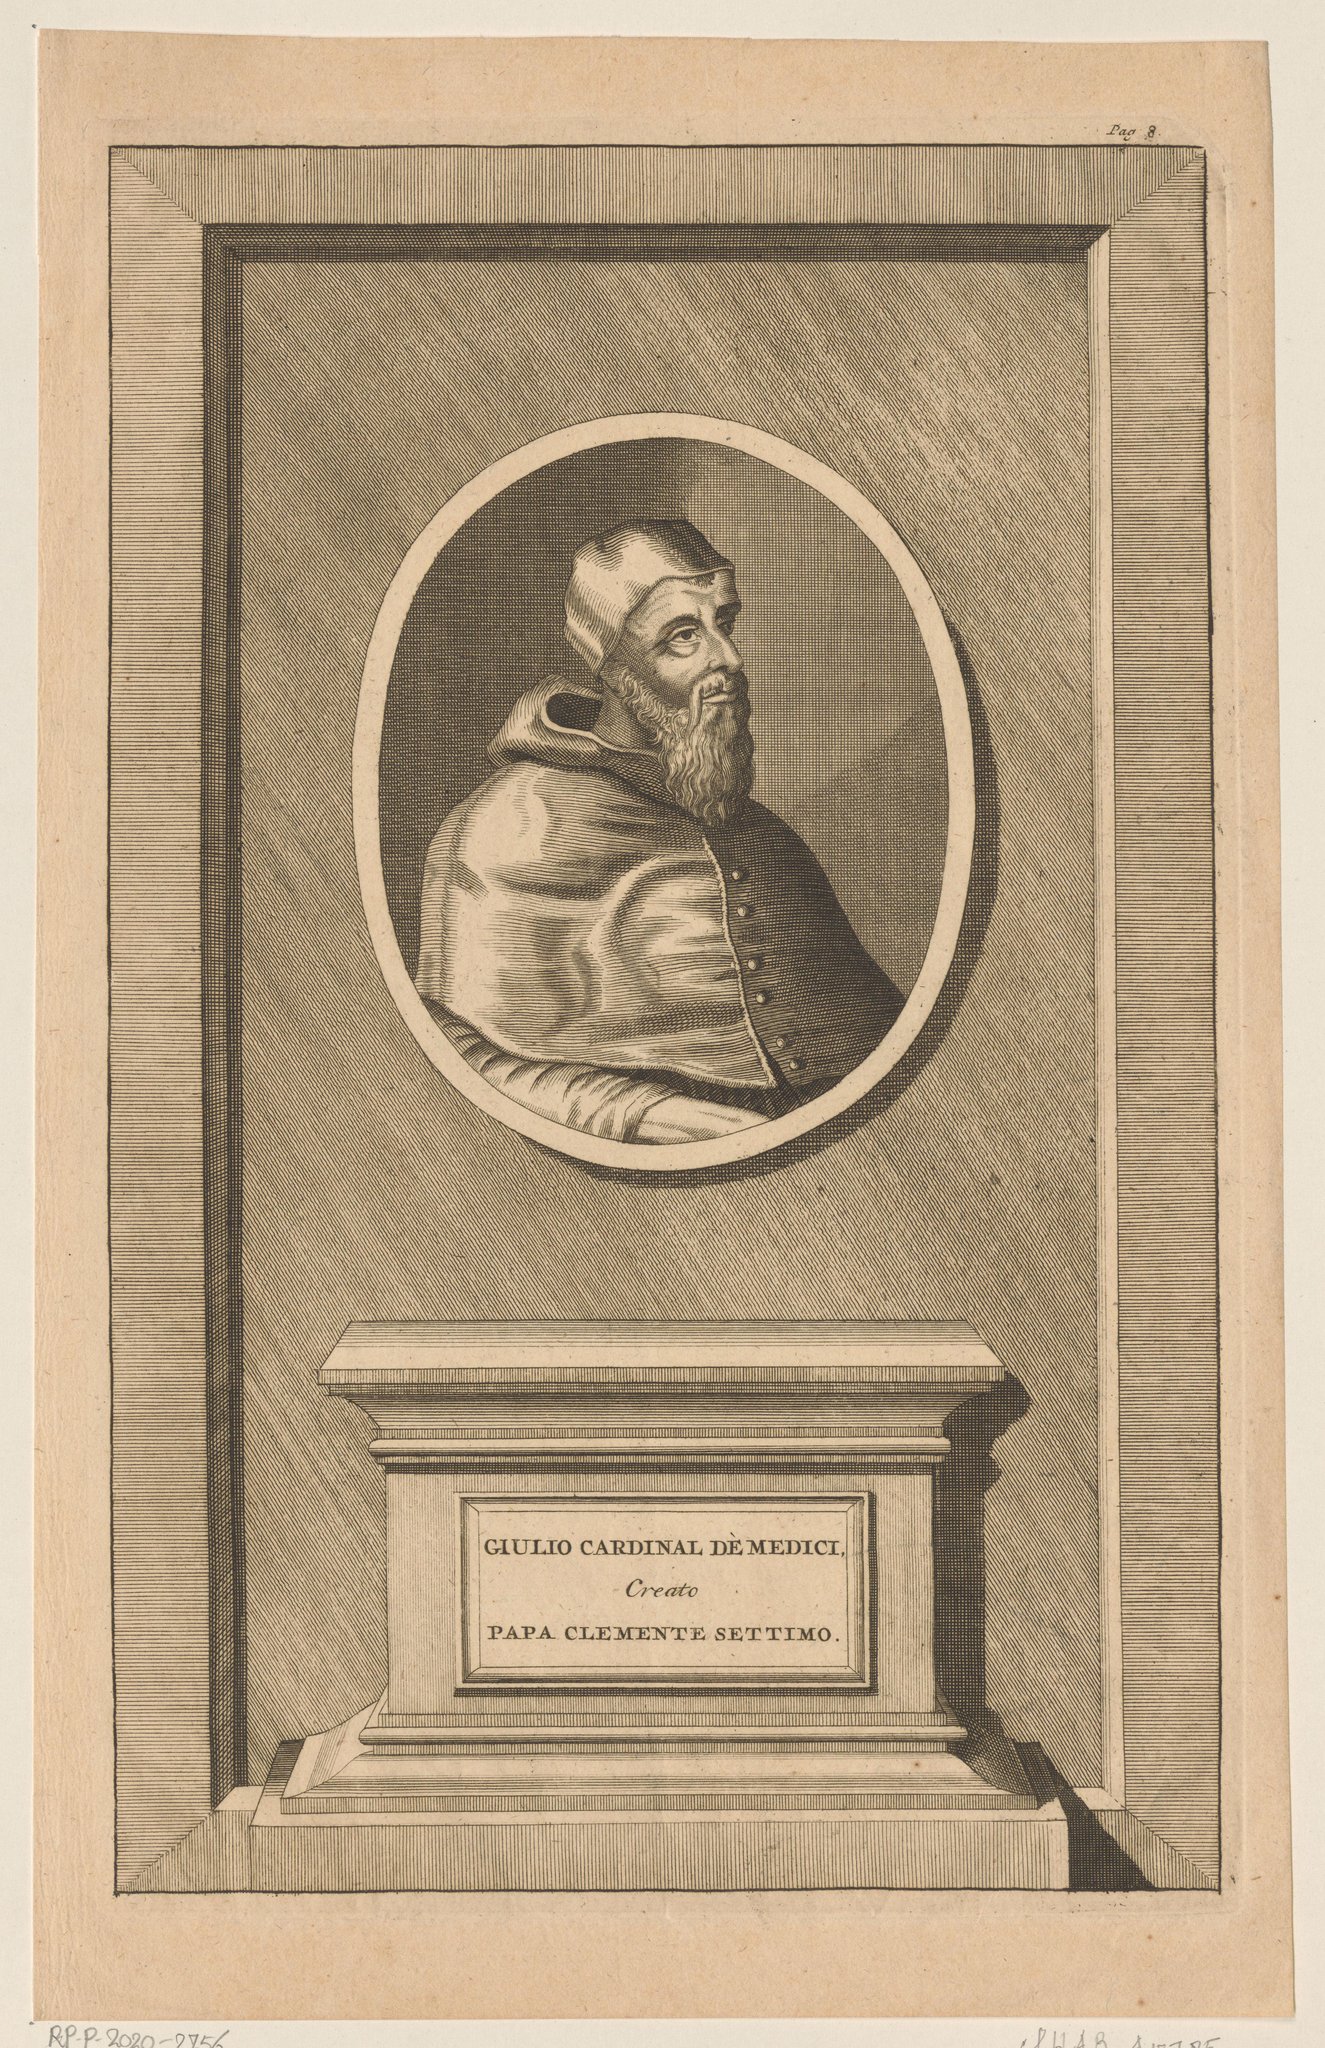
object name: print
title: Portret van paus Clemens VII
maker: Anonymous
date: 1700-1749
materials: paper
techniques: engraving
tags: rome, historical persons, pope